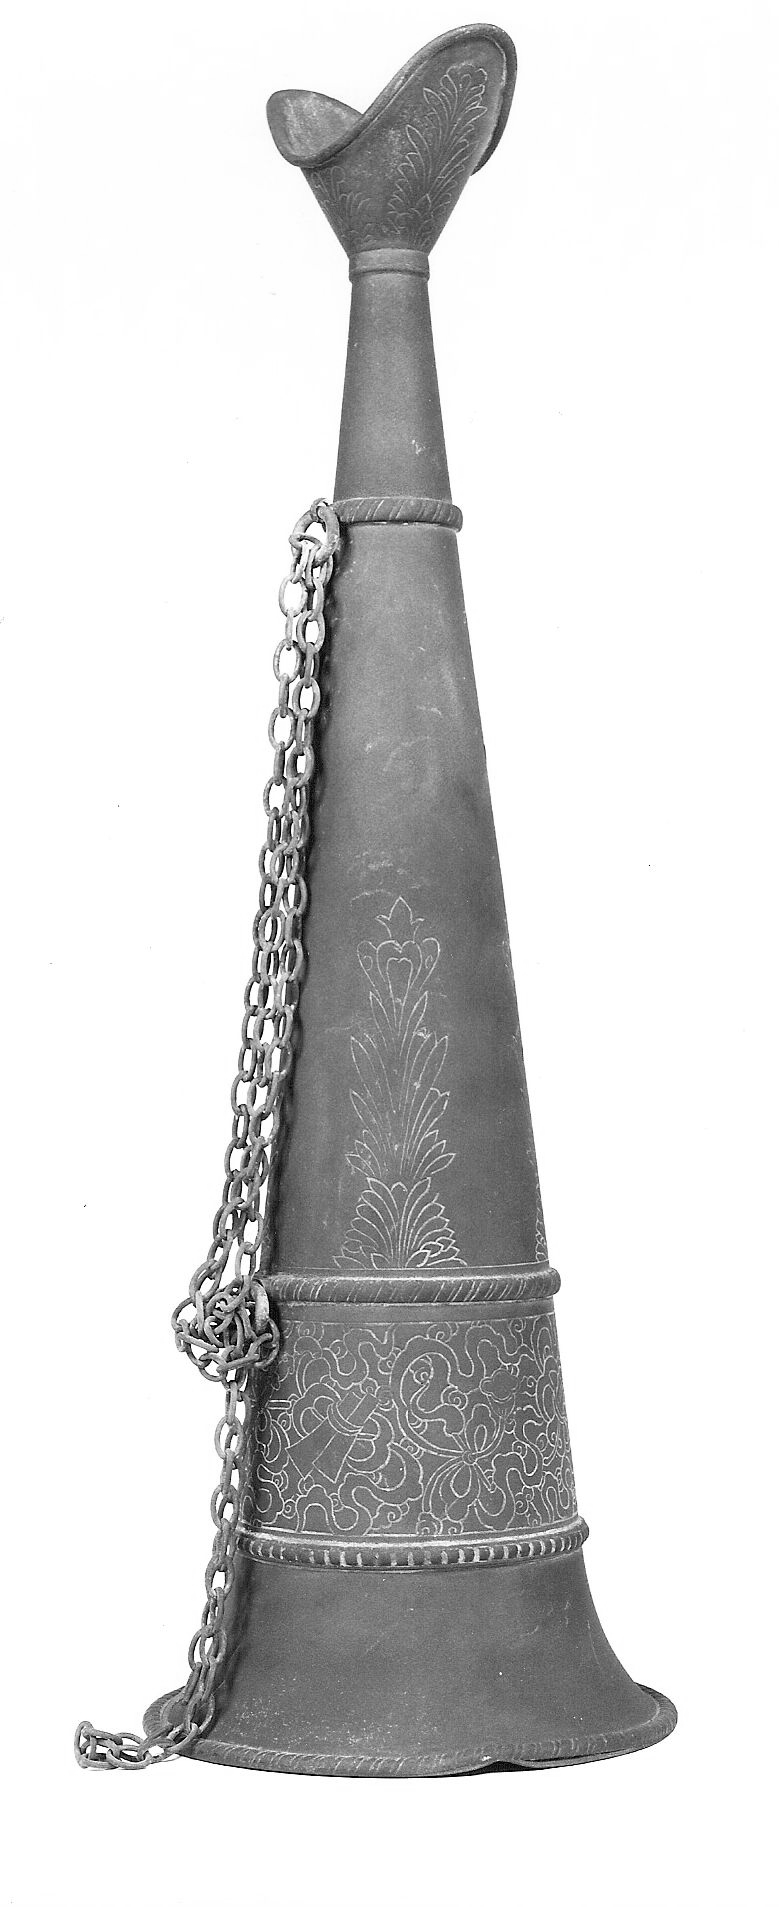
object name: fireman's trumpet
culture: american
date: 1834-1866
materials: metal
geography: united states